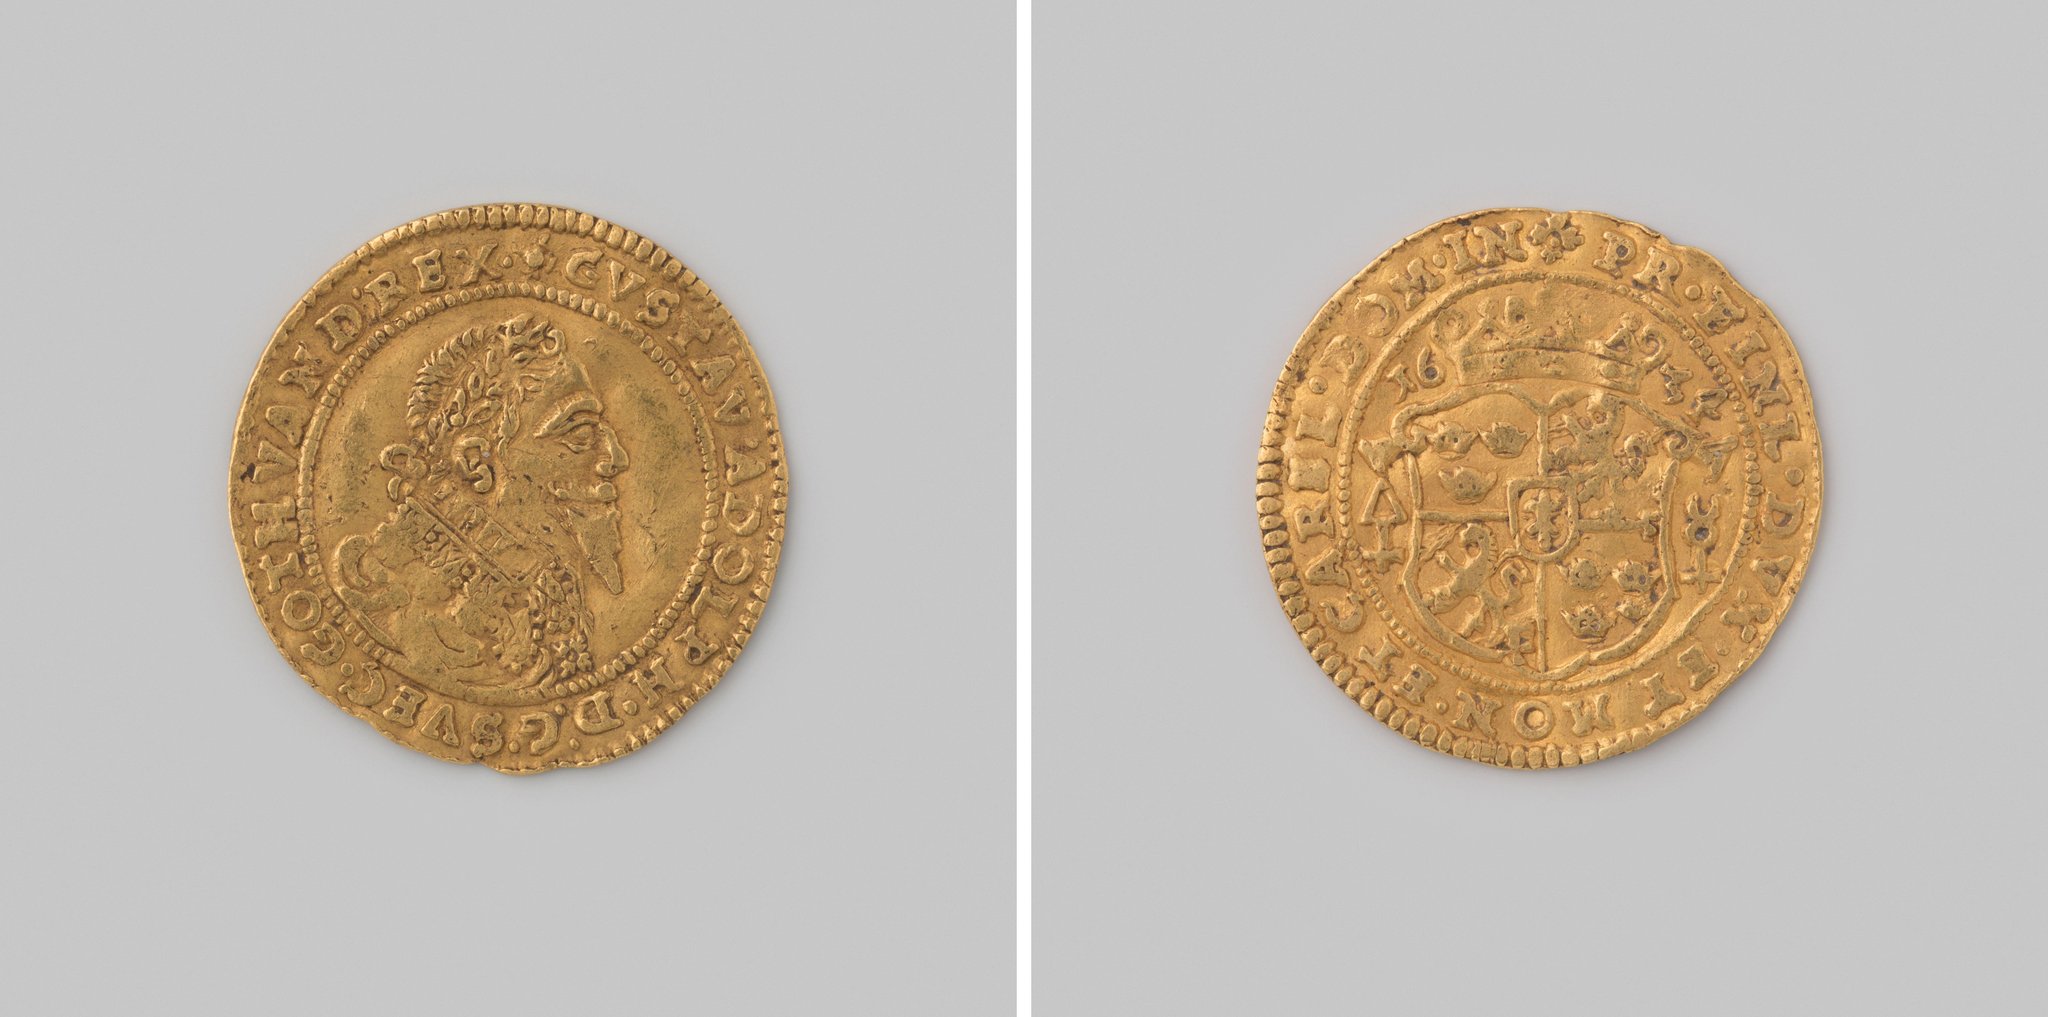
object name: ducat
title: Dukaat uit Erfurt van Gustaf II Adolf, 1634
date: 1634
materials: gold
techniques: striking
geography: erfurt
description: Gouden munt. Voorzijde: borstbeeld van de Zweedse koning naar rechts. Keerzijde: gekroond samengesteld wapenschild. Jaartal rondom kroon. Gladde rand.